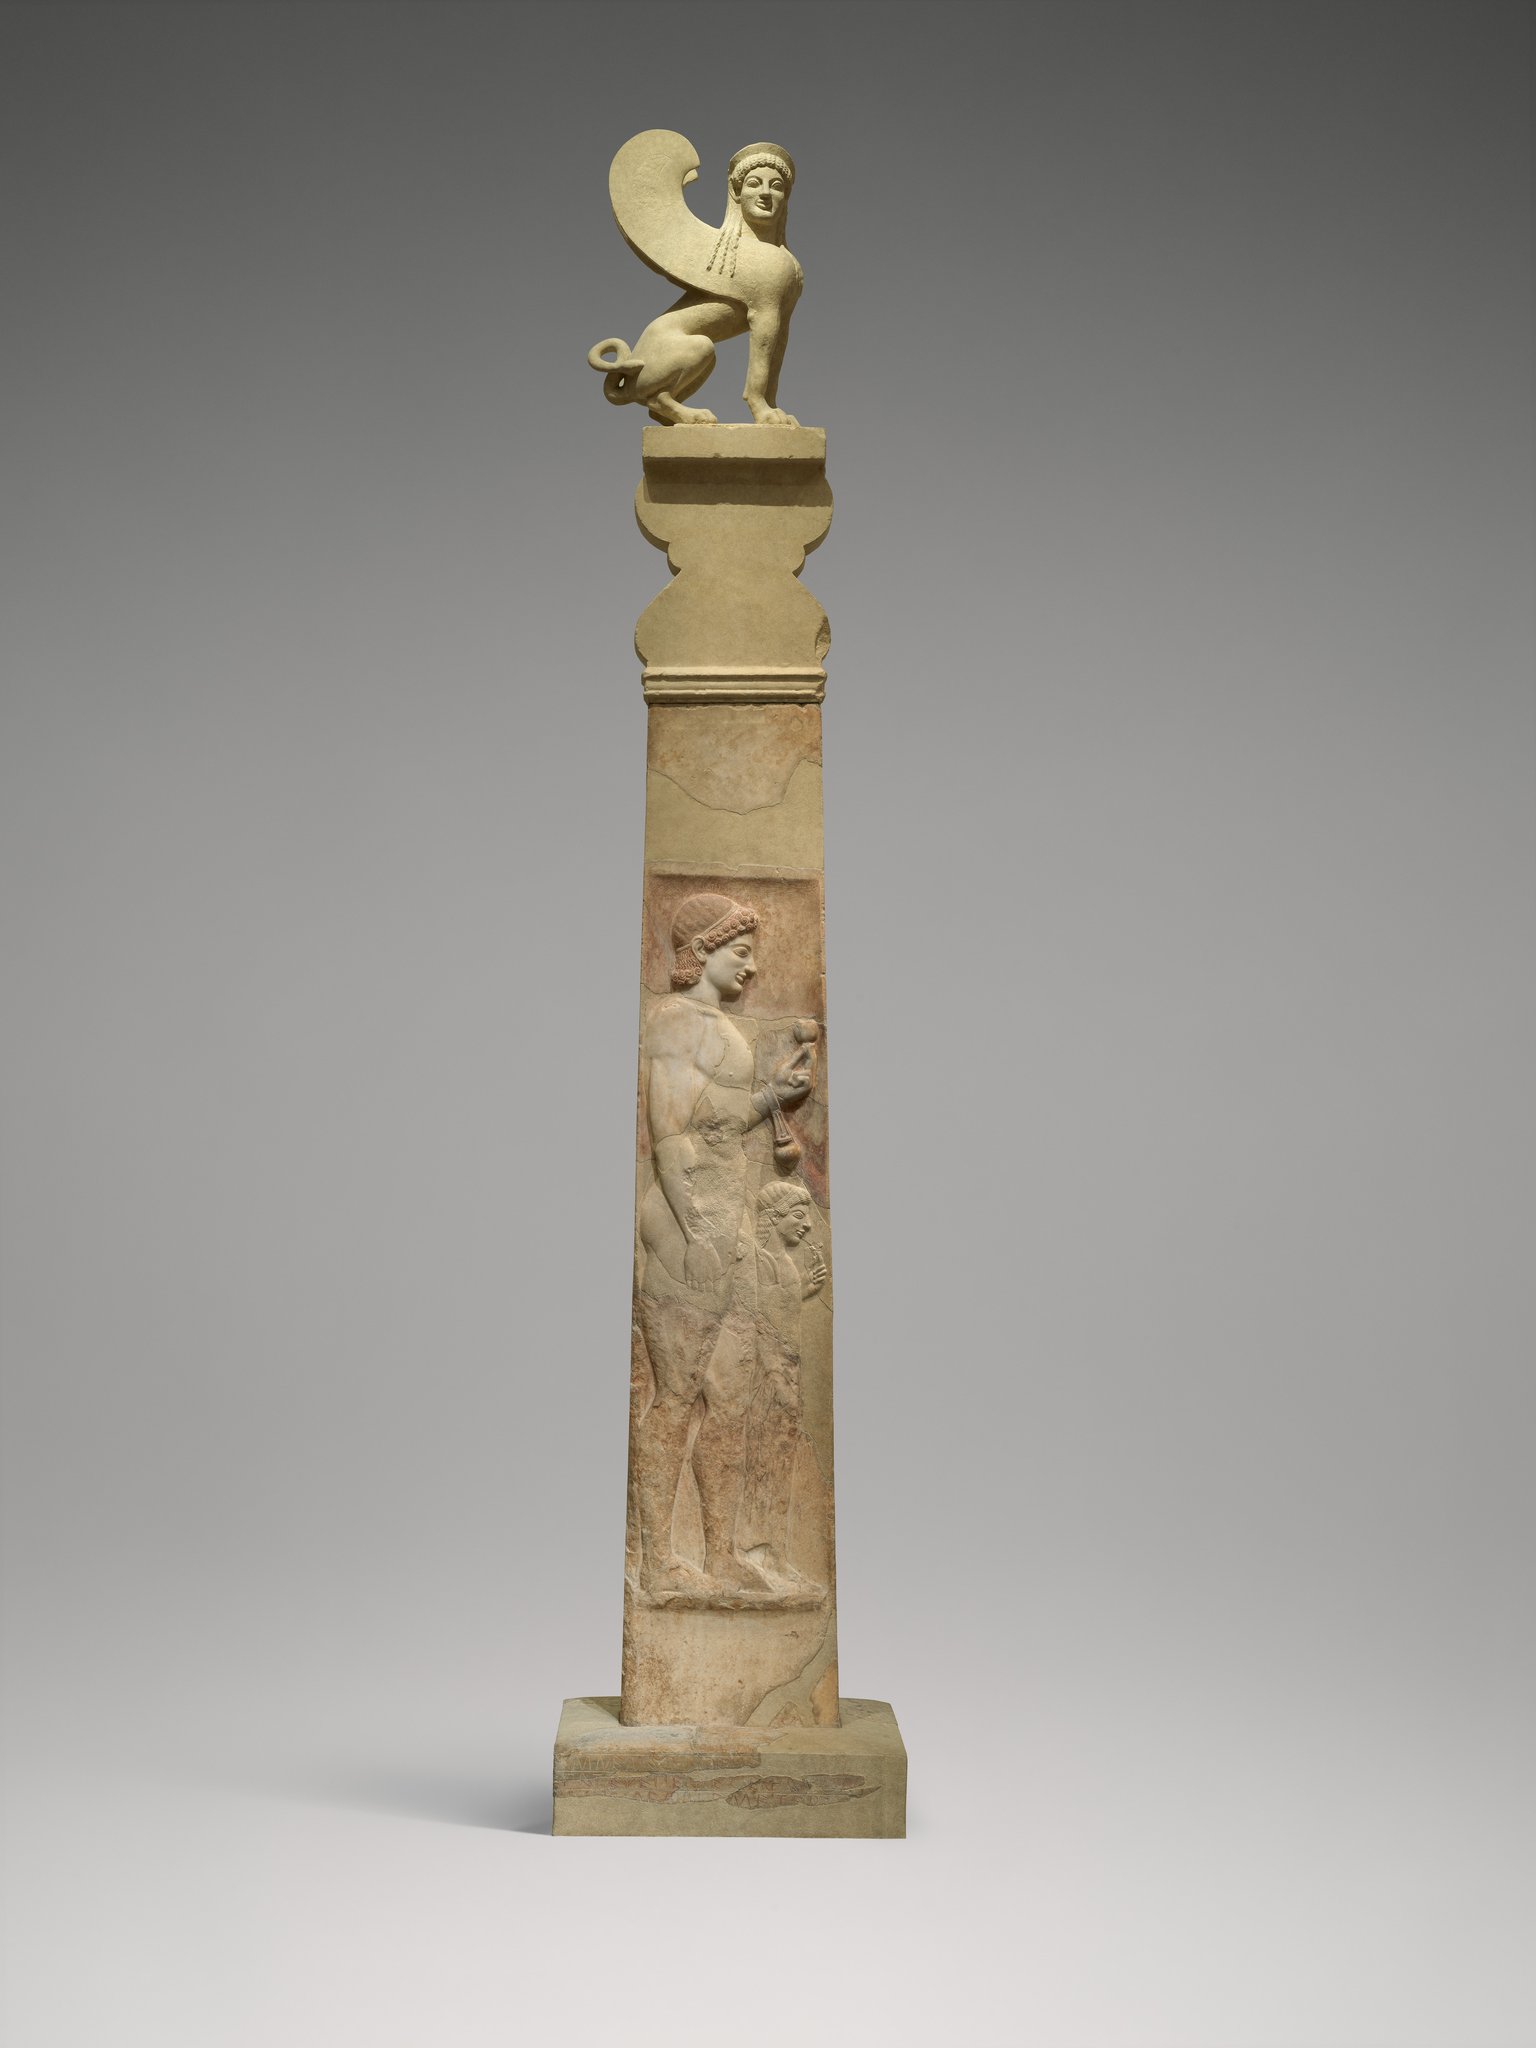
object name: grave stele of a little girl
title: Marble stele (grave marker) of a youth and a little girl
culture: greek, attic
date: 530 BCE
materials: marble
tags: girls,men,sphinx